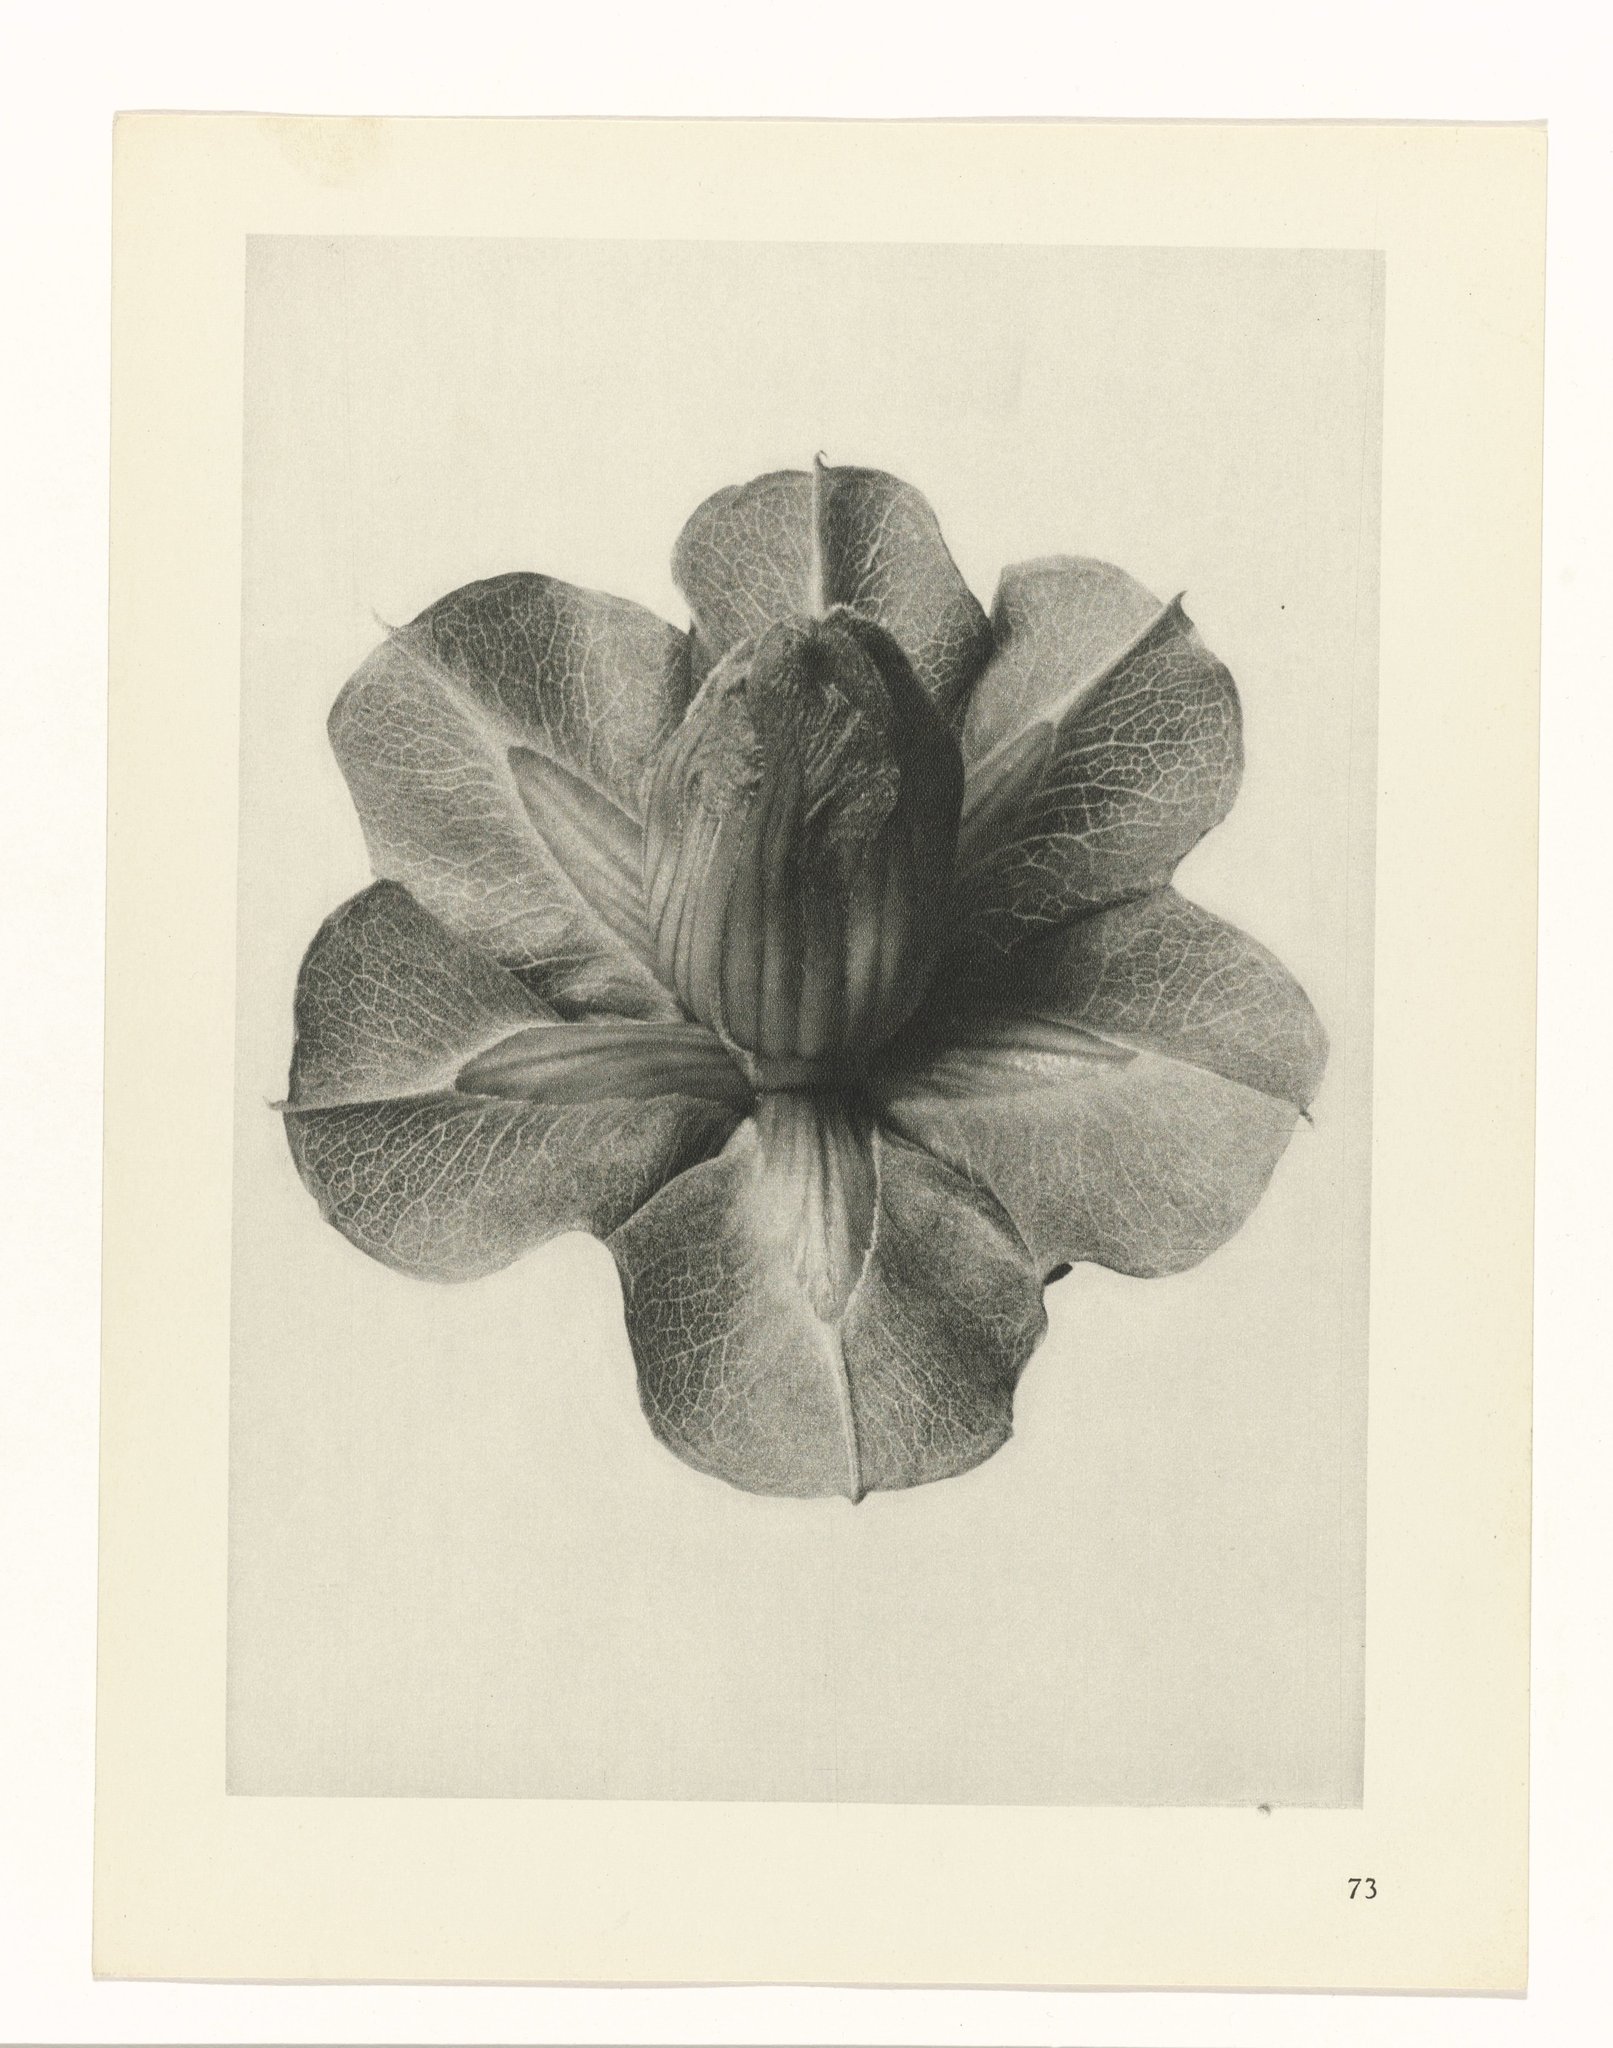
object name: photograph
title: Plant Studies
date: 1928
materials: ink, paper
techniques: rotogravure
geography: berlin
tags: plants (in general)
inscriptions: number: ‘73’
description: facher Vergrößerung. Afkomstig uit losbladige uitgave.